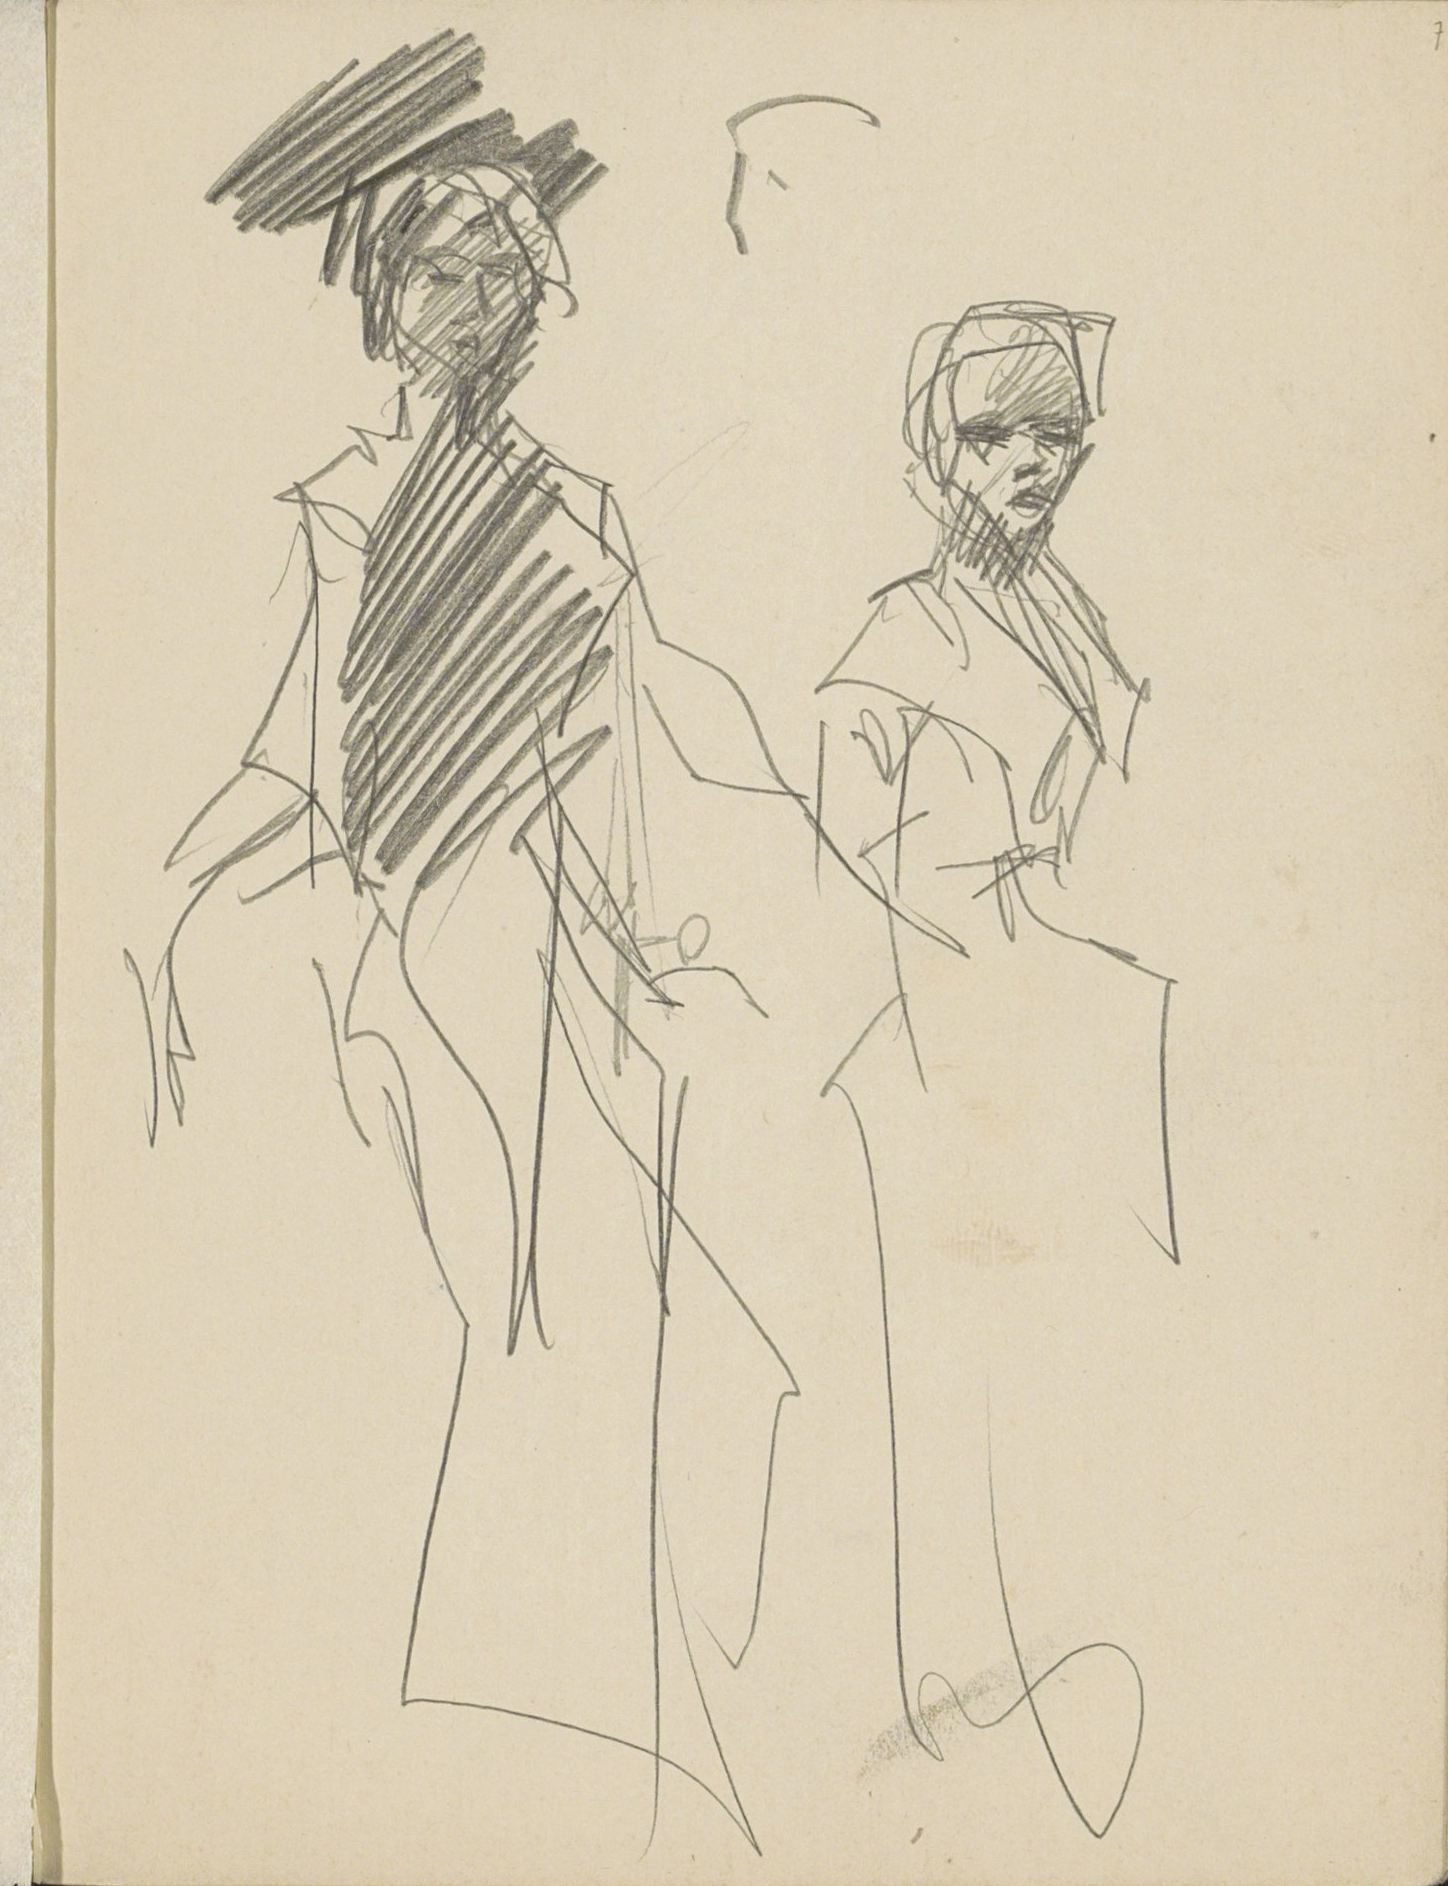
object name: sketchbook leaf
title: Twee staande vrouwen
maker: isaac israels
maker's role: draughtsman, painter, print maker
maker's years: 1865-1934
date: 1921-1922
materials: paper, pencil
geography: dutch east indies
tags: asiatic races and peoples, adult woman (+ standing), dutch east indies, the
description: Pagina 7 uit schetsboek XXXIV met 24 pagina's.